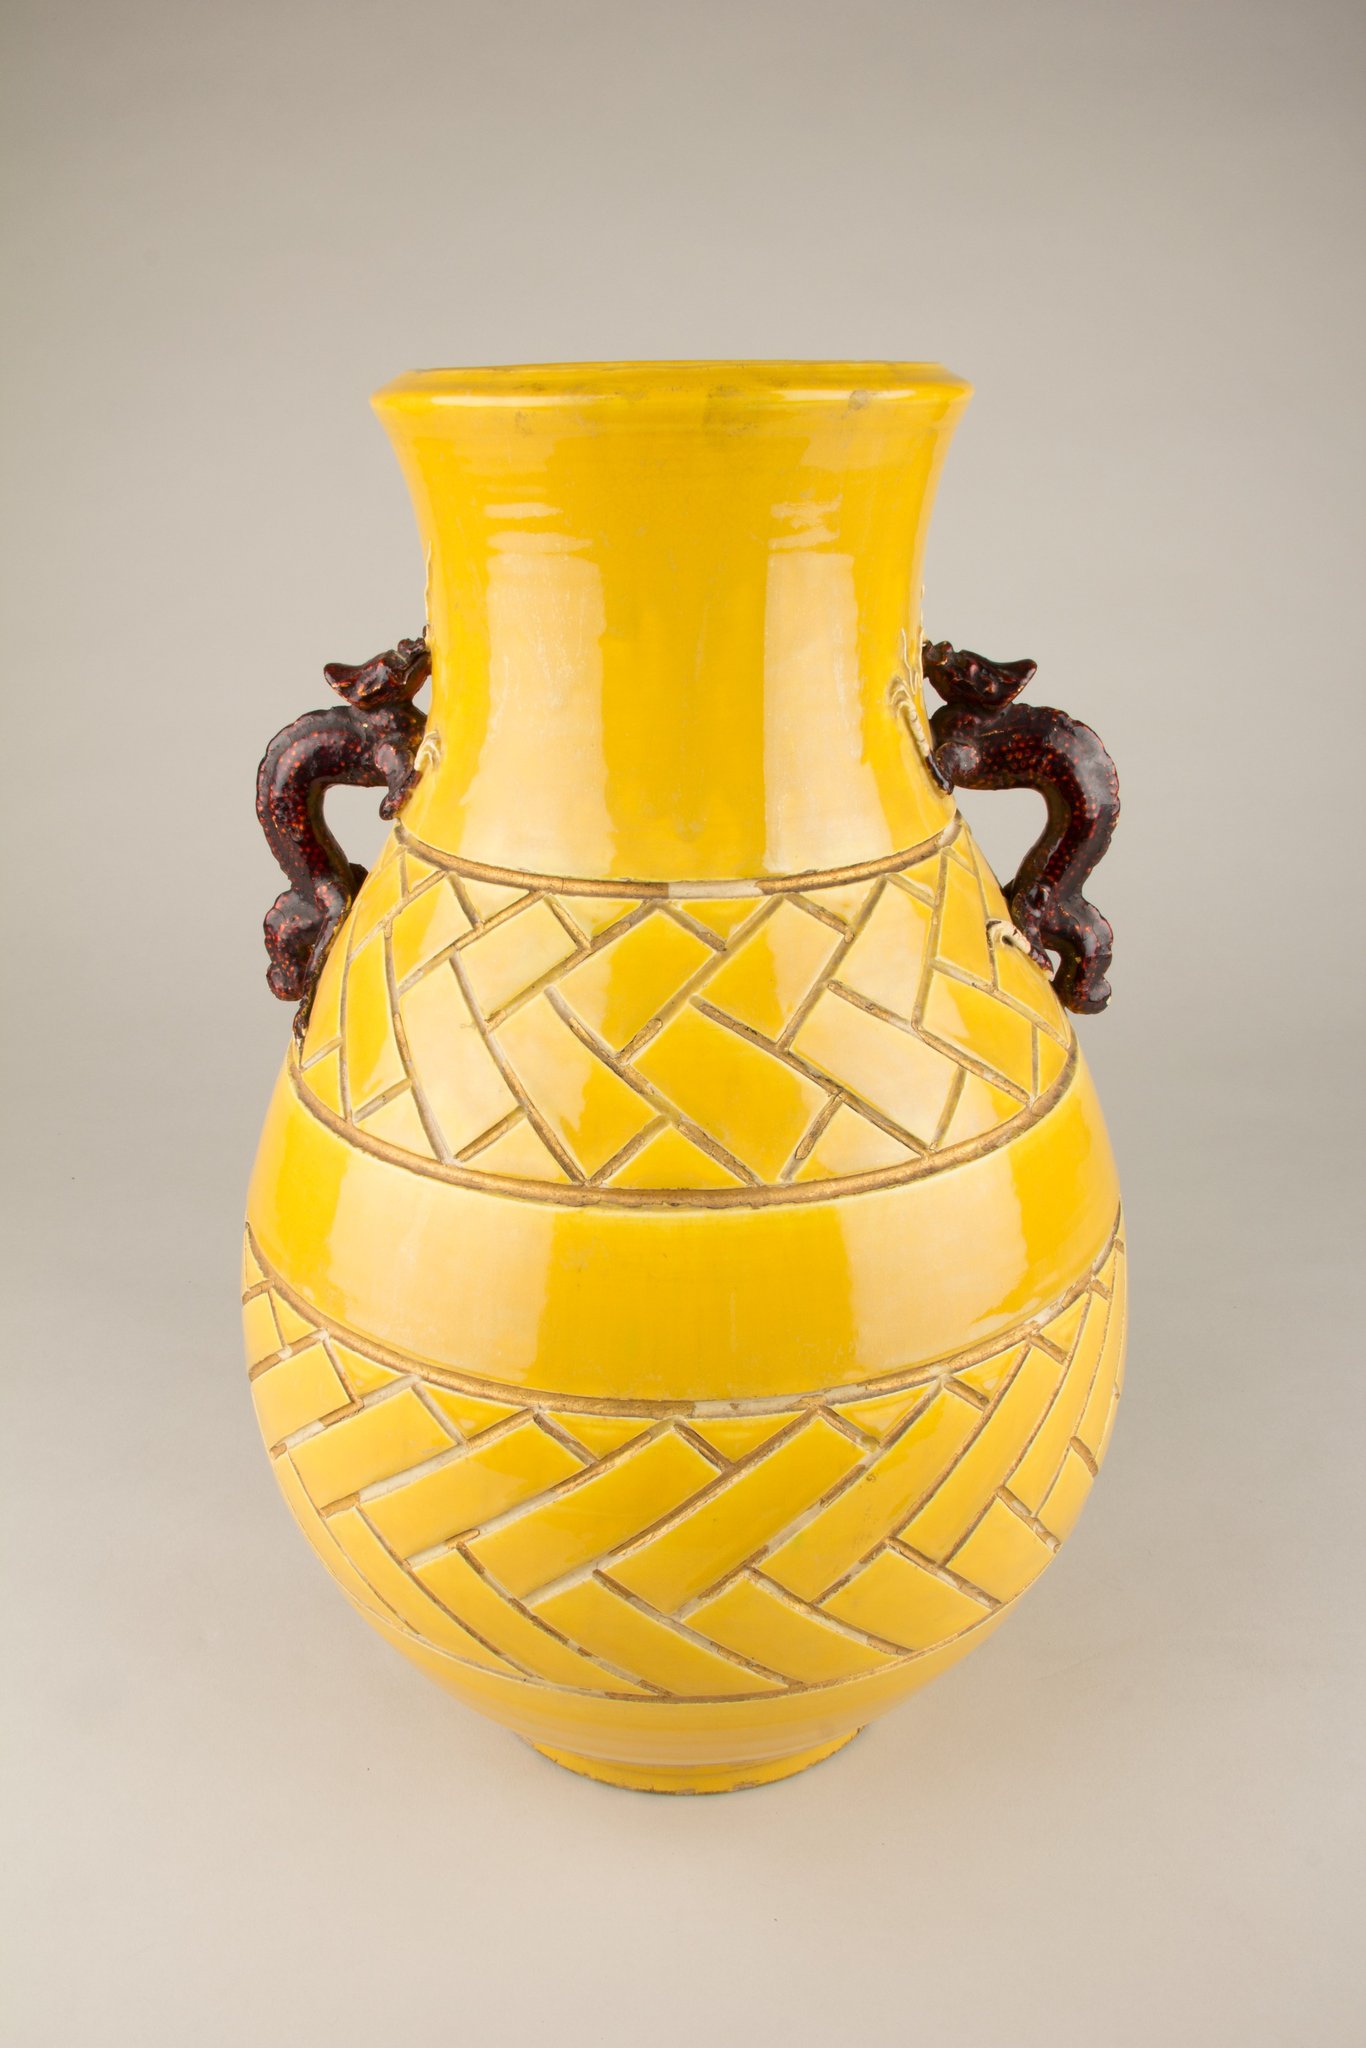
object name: vase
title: Vase with Incised Design and Salamander Handles in Kochi Style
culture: japanese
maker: eiraku hozen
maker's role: artist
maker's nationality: japanese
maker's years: 1795-1854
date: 1801-1850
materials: gilt, glaze, stoneware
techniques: incising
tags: salamanders